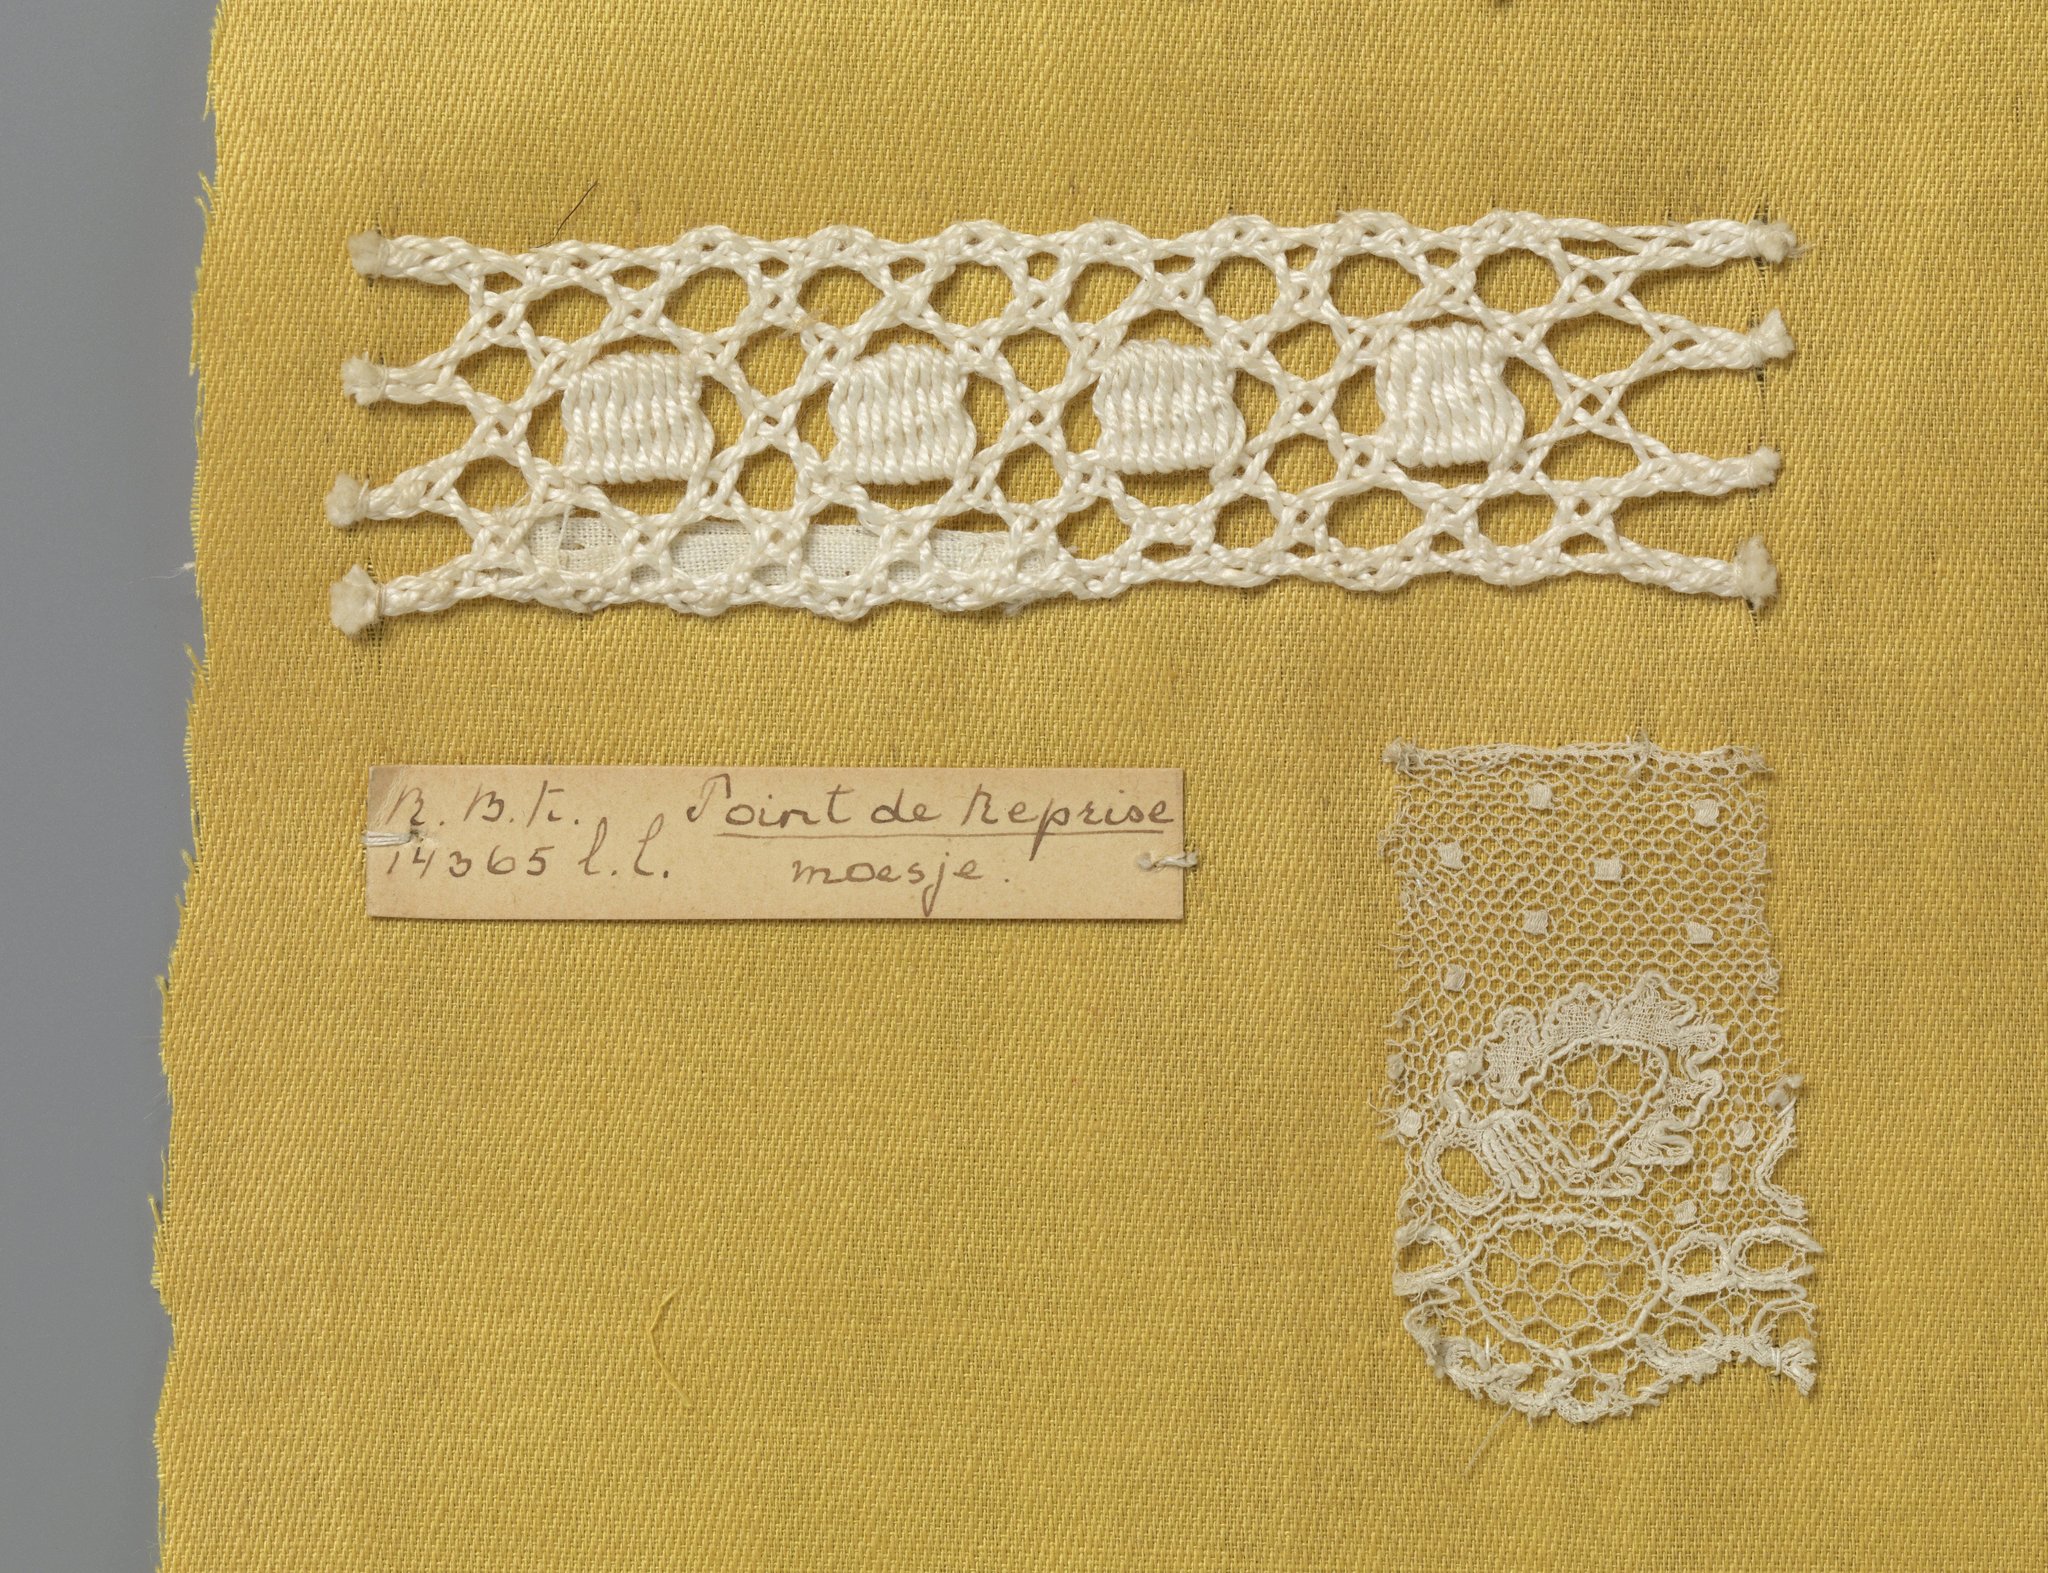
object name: sample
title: Staal kloskant met grove draad als voorbeeld van moesjes in vormslag met daarbij een fragment Rijselse kant waarin deze techniek is toegepast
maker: Anonymous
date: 1900-1930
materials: cotton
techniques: lace, tally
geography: western europe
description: Staal naturelkleurige kloskant met grove draad als voorbeeld van moesjes in vormslag met daarbij een fragment Rijselse kant waarin deze techniek is toegepast. In het staal is een stroptraliegrond gebruikt, in het fragment een tulegrond. De datering betreft het staal.